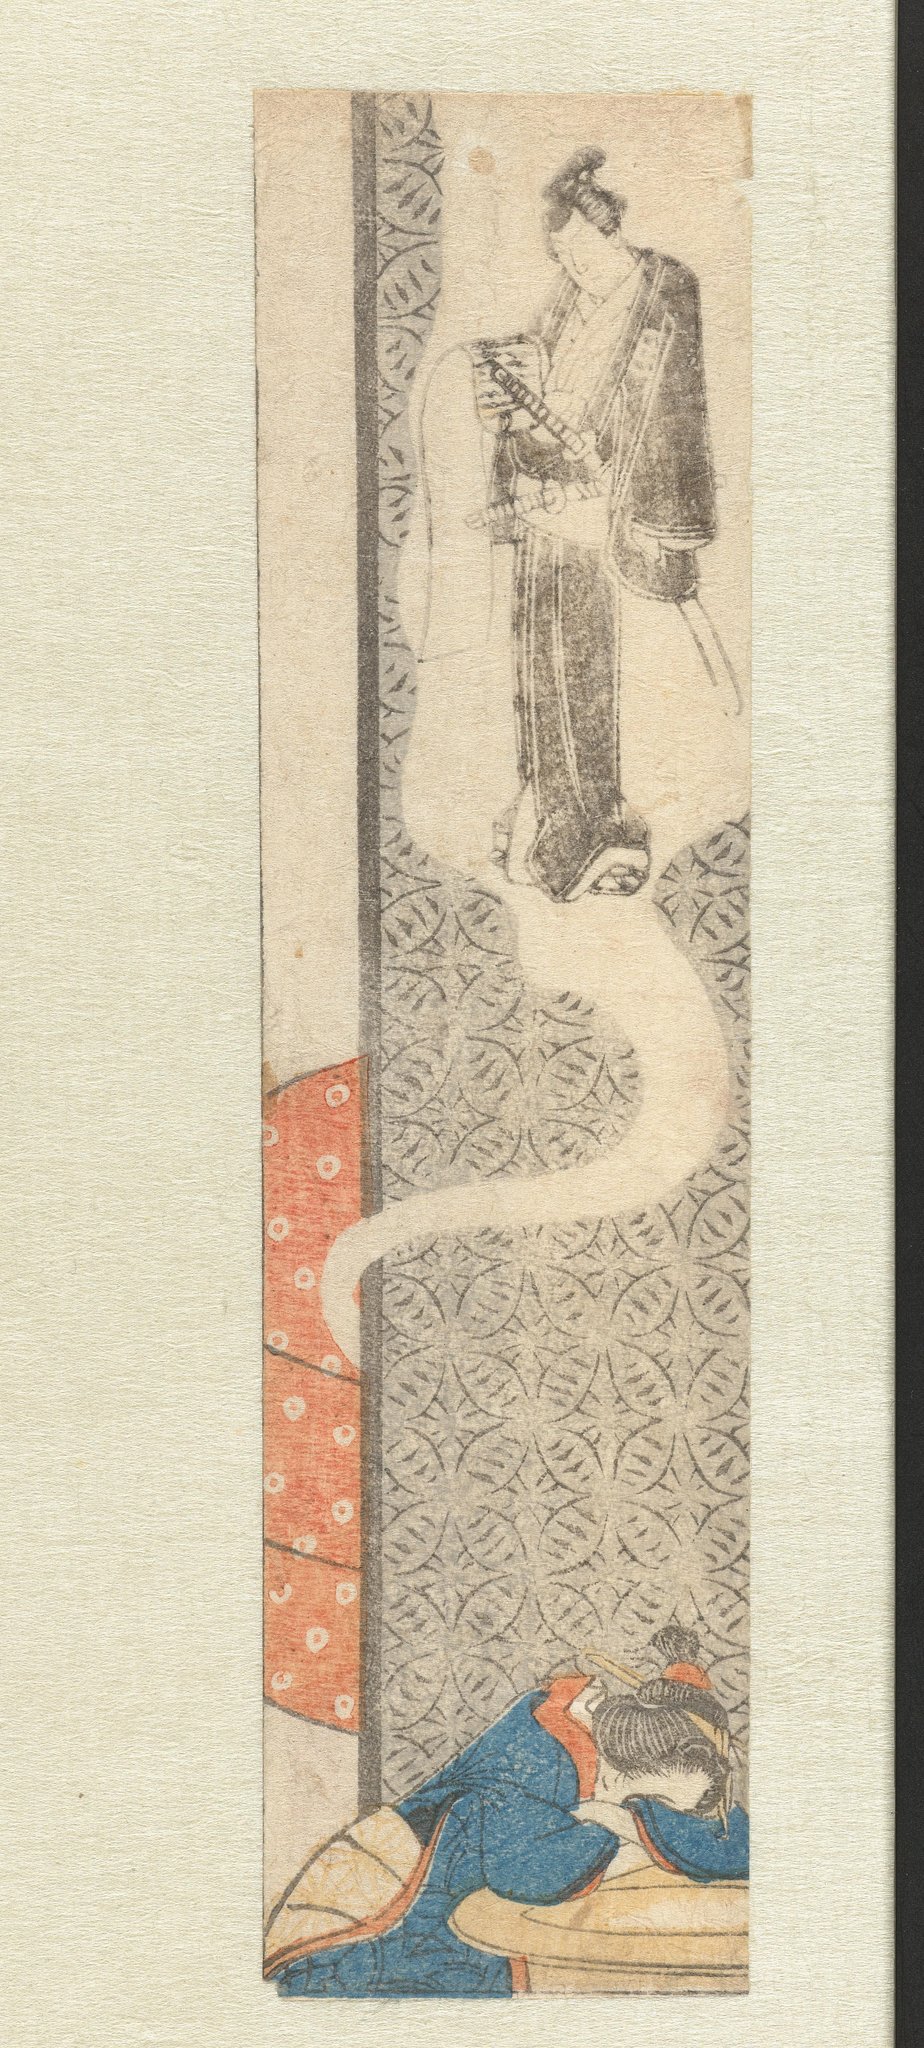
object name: envelope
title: Dromende courtisane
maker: utagawa hiroshige (i)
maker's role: draughtsman, print maker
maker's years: 1797-1858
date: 1845-1850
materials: paper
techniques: woodcut, nishiki e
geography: japan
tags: dream, sleeping; unconsciousness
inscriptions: collector's mark: Lugt 2228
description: Voorkant van envelop met afbeelding van slapend dienstmeisje en droom van slapende vrouw achter kamerscherm over haar geliefde met brief.